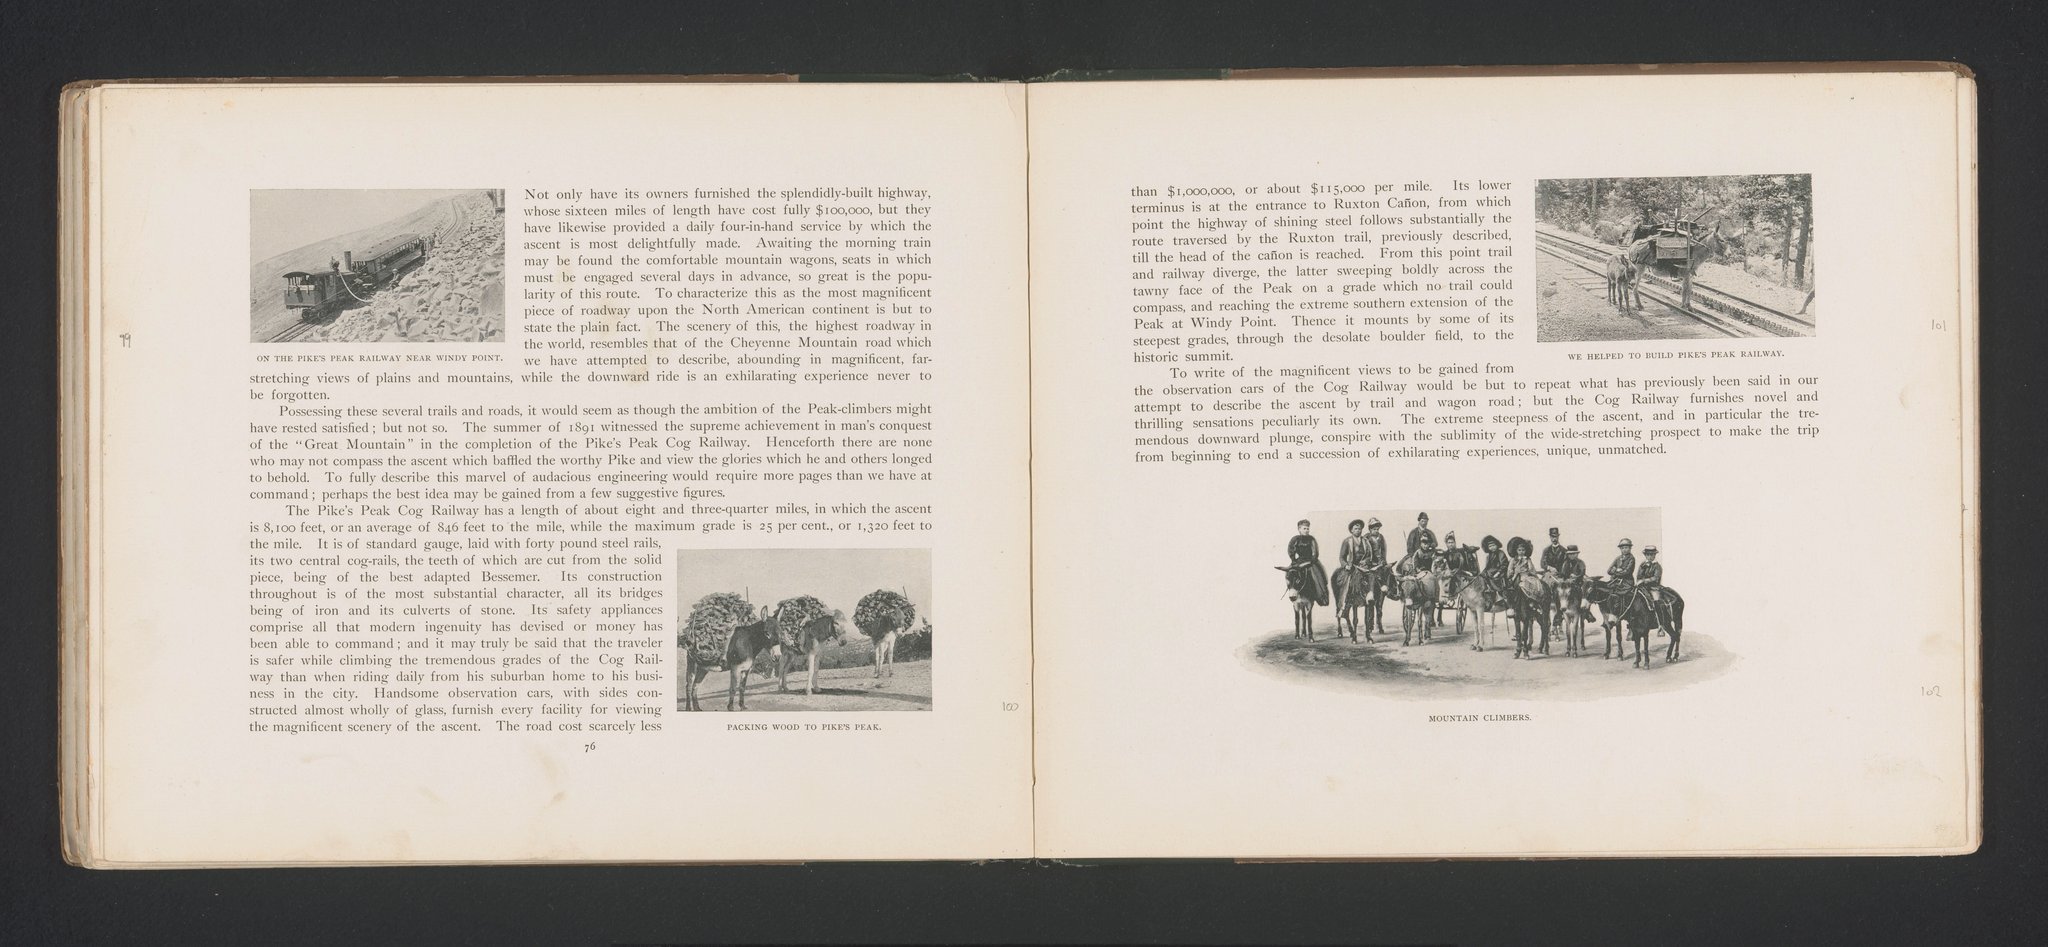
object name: page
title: Gezicht op de spoorweg met trein van Pikes Peak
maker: Anonymous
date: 1888-1893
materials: paper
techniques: autotype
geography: colorado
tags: mountain-top, peak, railway, train